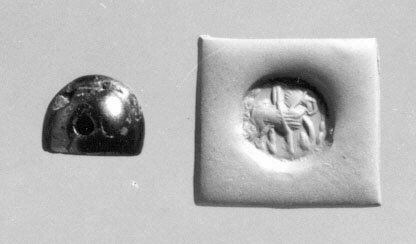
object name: stamp seal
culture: sasanian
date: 201-700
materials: mineral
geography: iran or mesopotamia